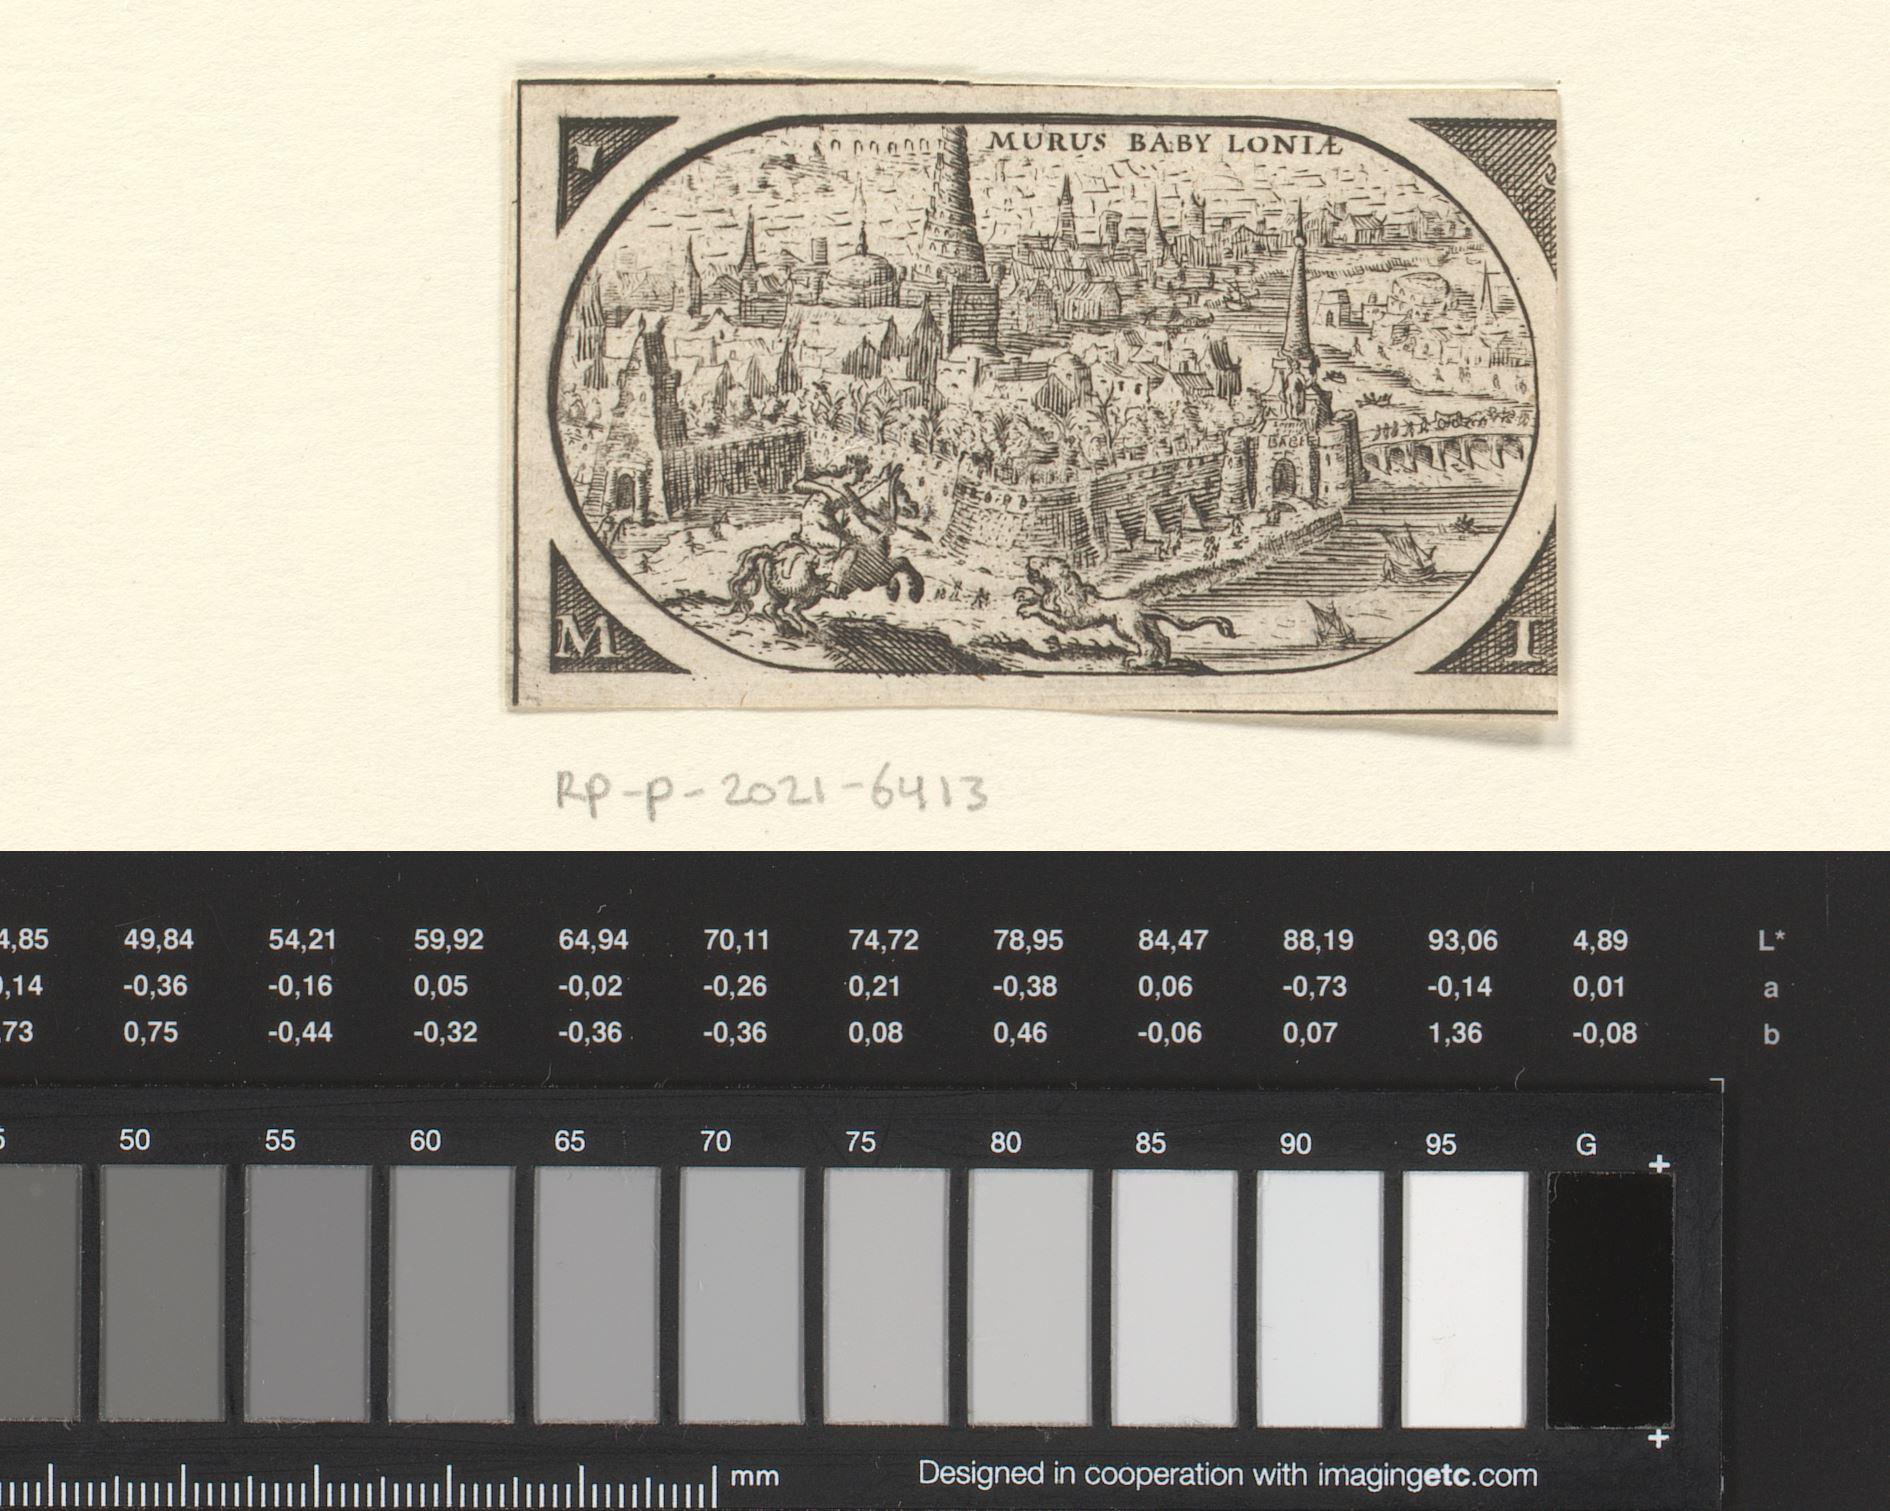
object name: print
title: Murus Baby Loniae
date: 1606-1656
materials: paper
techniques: engraving, etching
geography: amsterdam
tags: hanging gardens of semiramis at babylon (wonder of the world)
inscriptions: collector's mark: Lugt 2228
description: De prent is afgesneden van de kaart 'Nova totius terrarum orbis geographica ac hydrographica tabula', voor het eerst in 1606 uitgegeven door Willem Janszoon Blaeu. De voorstellingen aan de onderkant van deze kaart zijn gekopieerd naar de serie 'De acht wereldwonderen', door Philips Galle naar Maarten van Heemskerck.